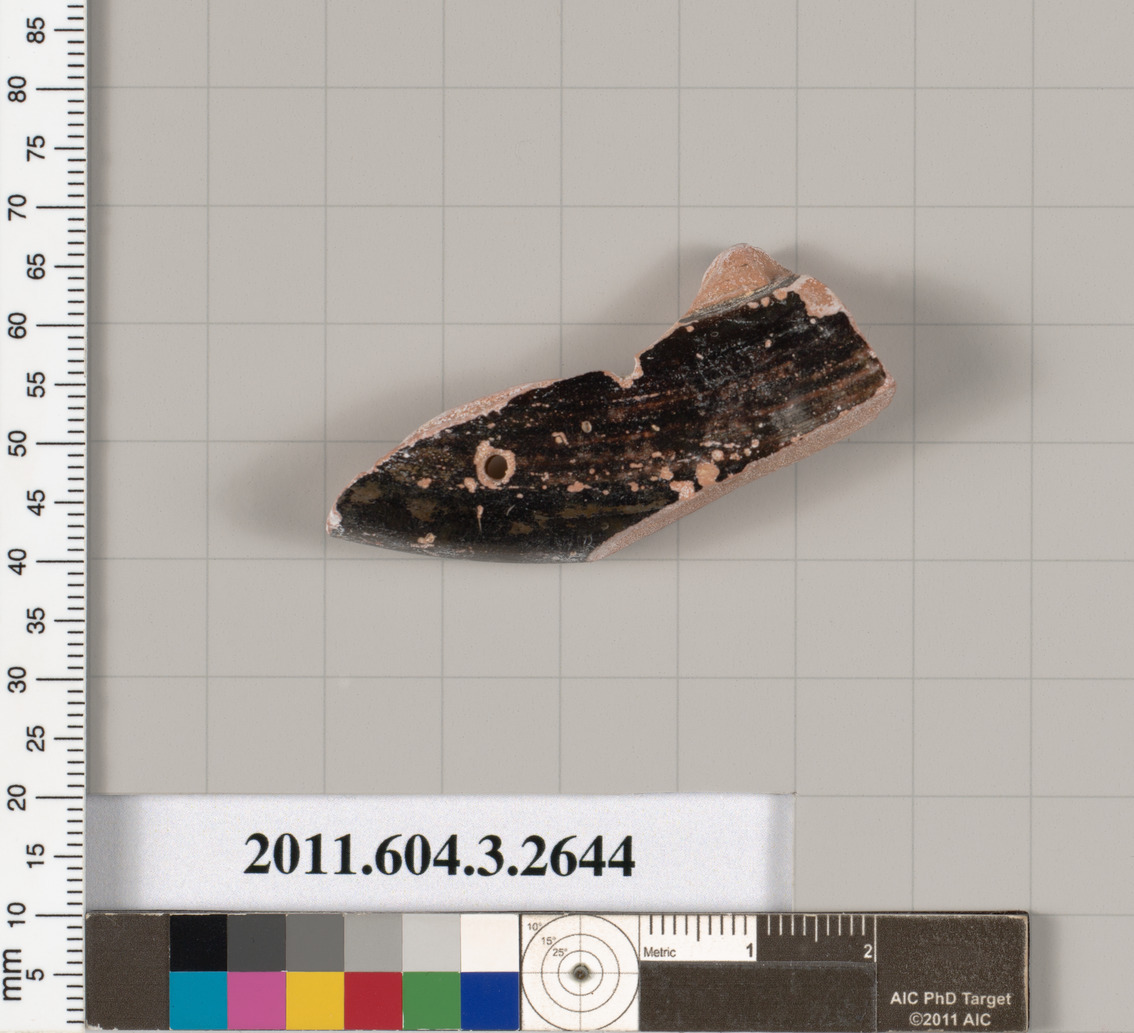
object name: undetermined shape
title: Terracotta fragment of an undetermined shape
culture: greek, attic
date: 600-501 BCE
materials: terracotta